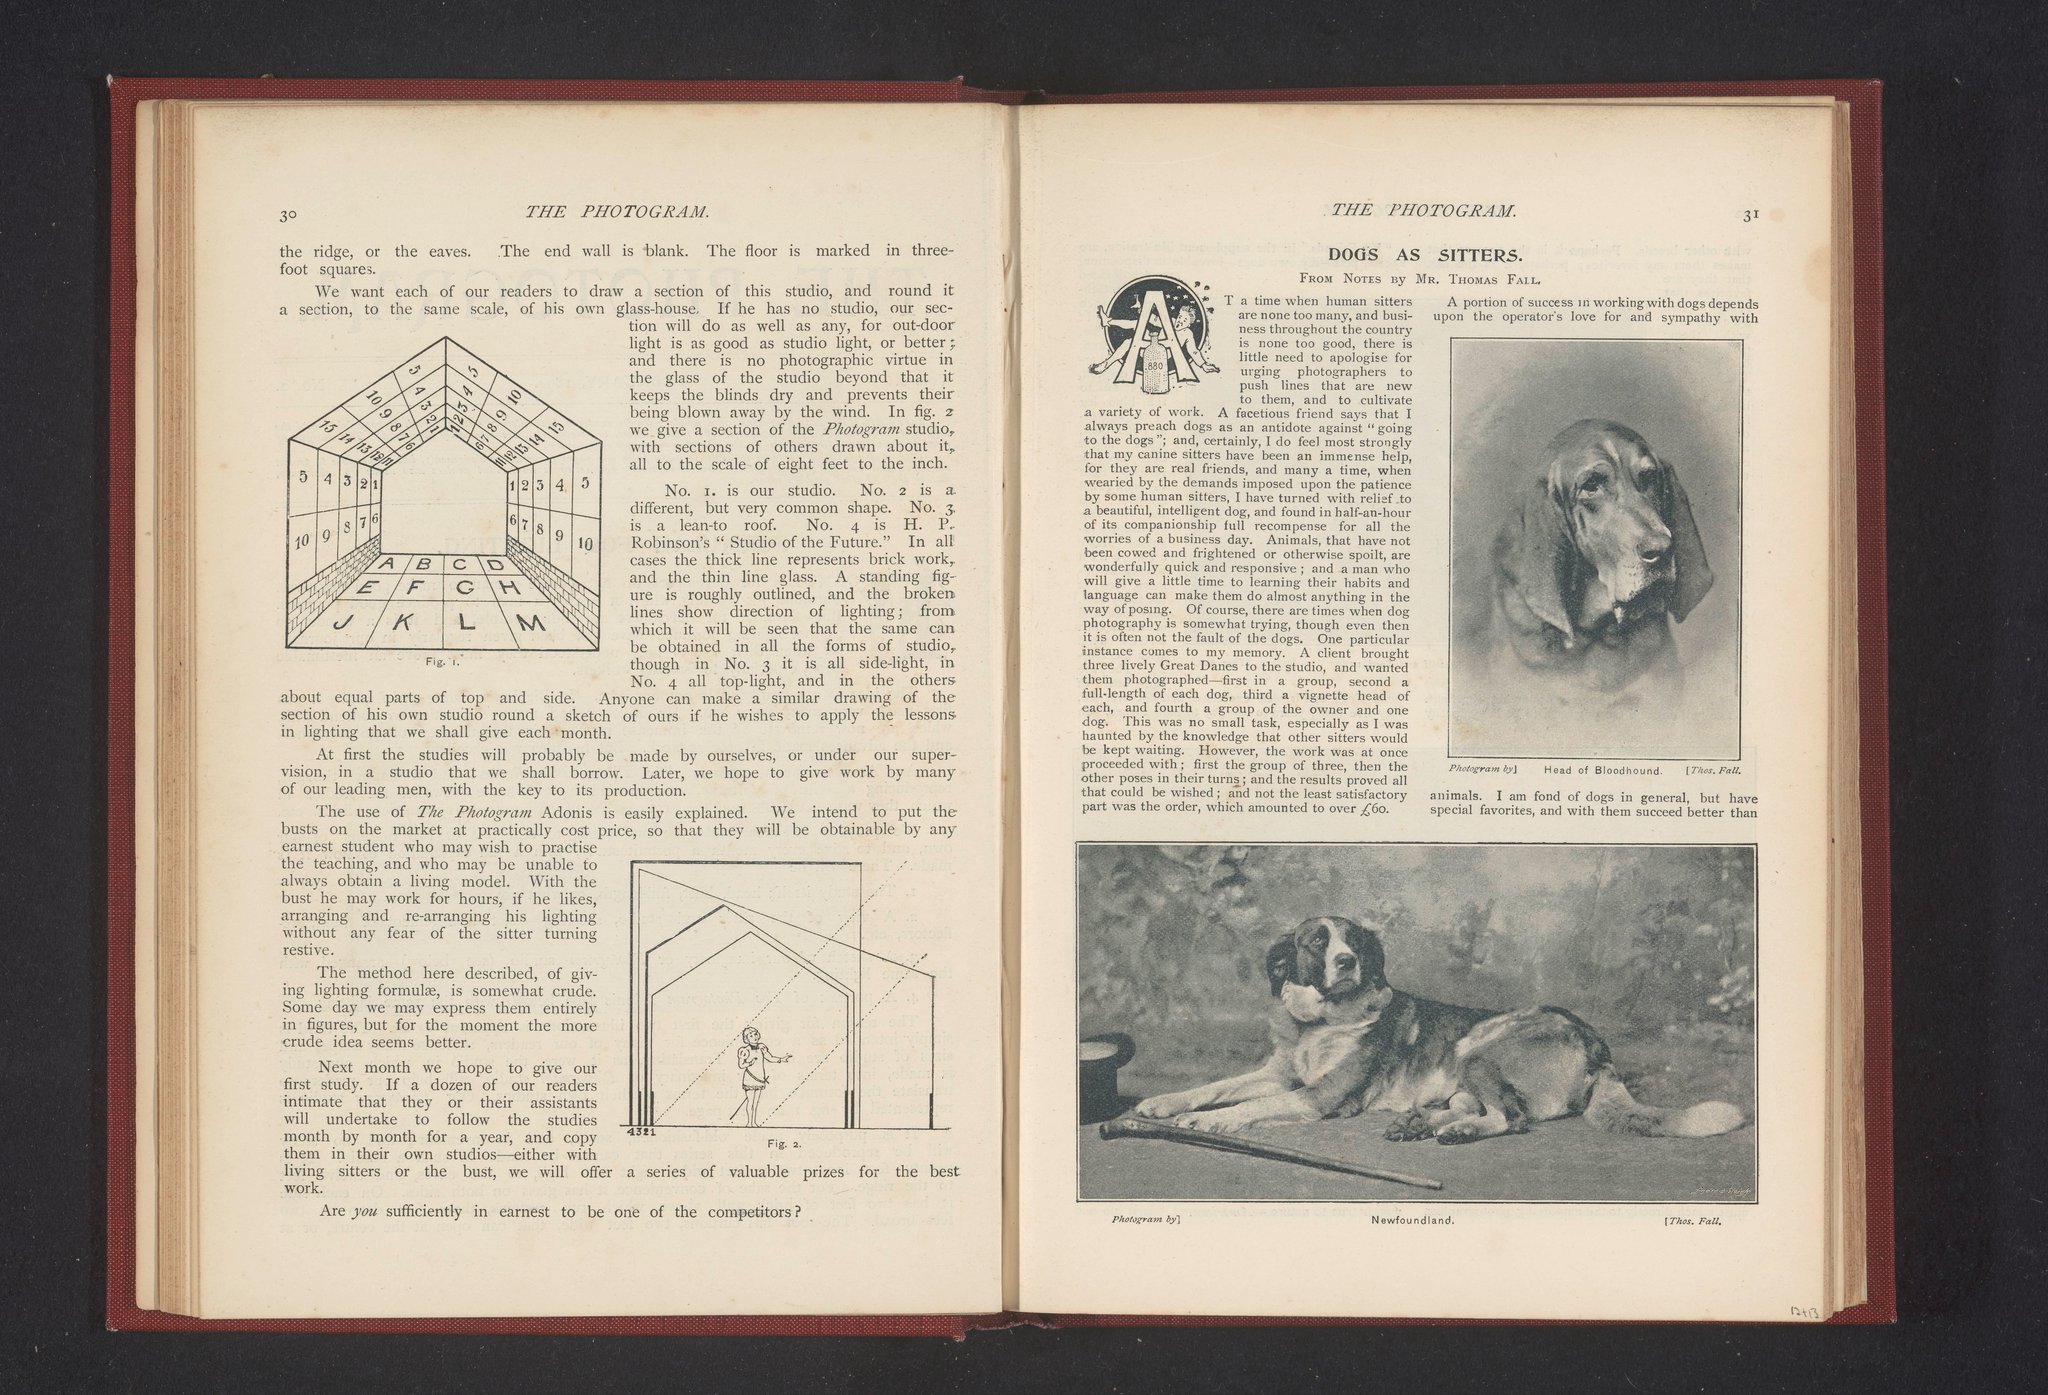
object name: page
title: Newfoundland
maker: thomas fall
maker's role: fotograaf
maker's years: 1833-1900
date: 1889-1894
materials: paper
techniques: autotype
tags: dog